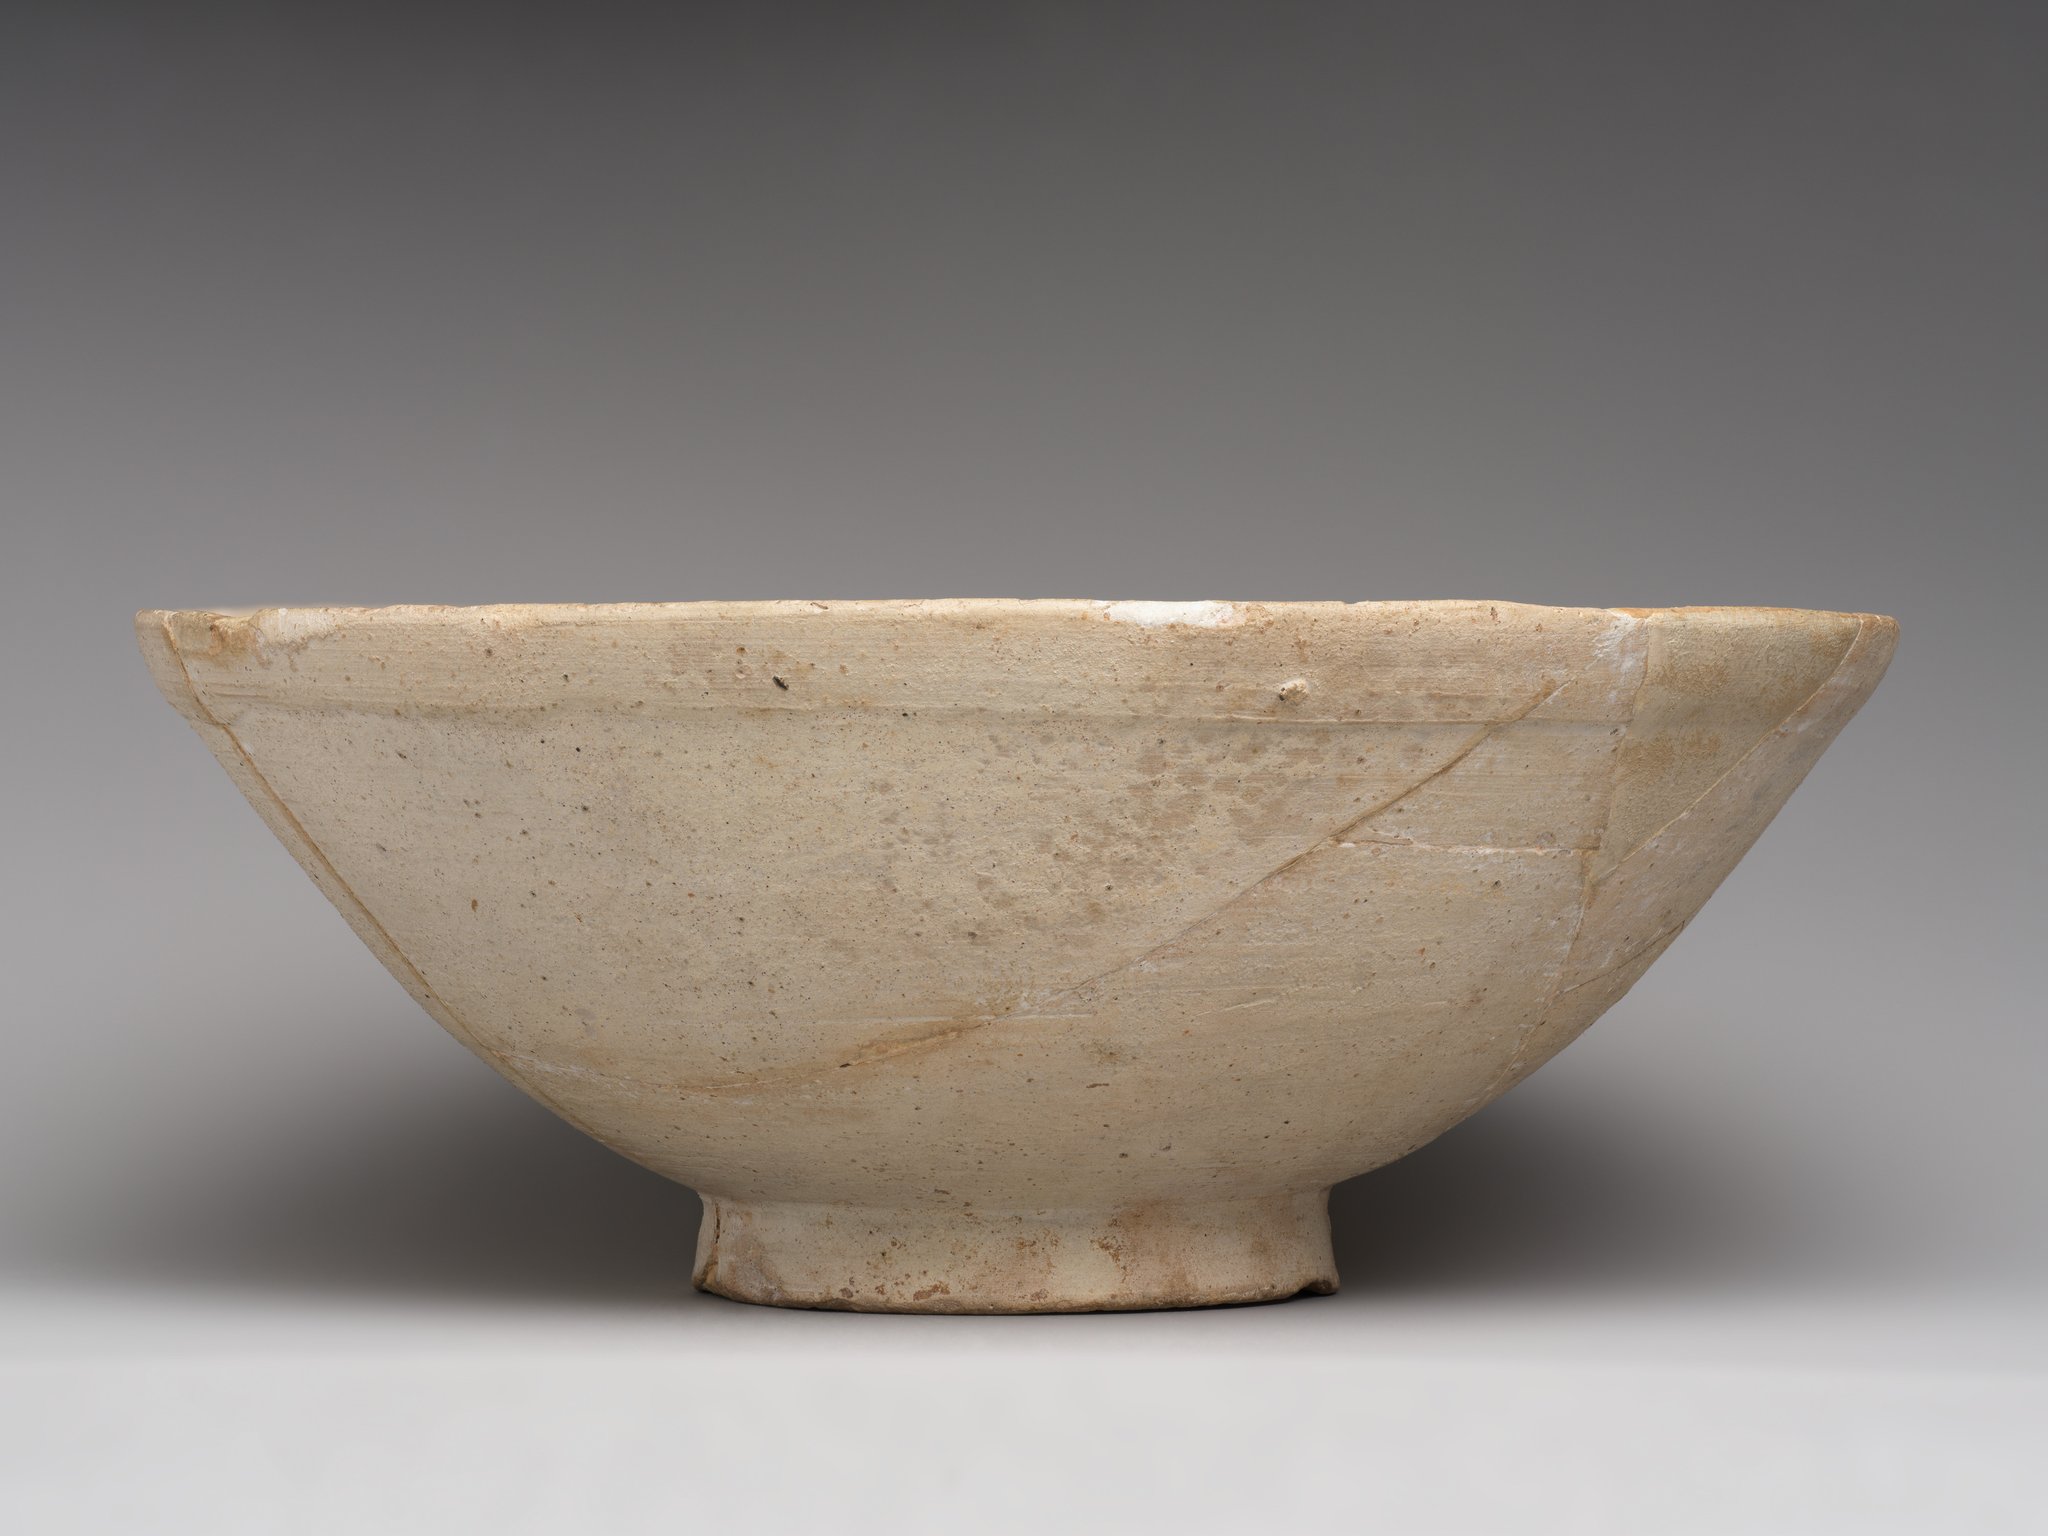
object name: bowl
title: Glazed bowl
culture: sasanian or islamic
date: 501-800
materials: ceramic, glaze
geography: iran